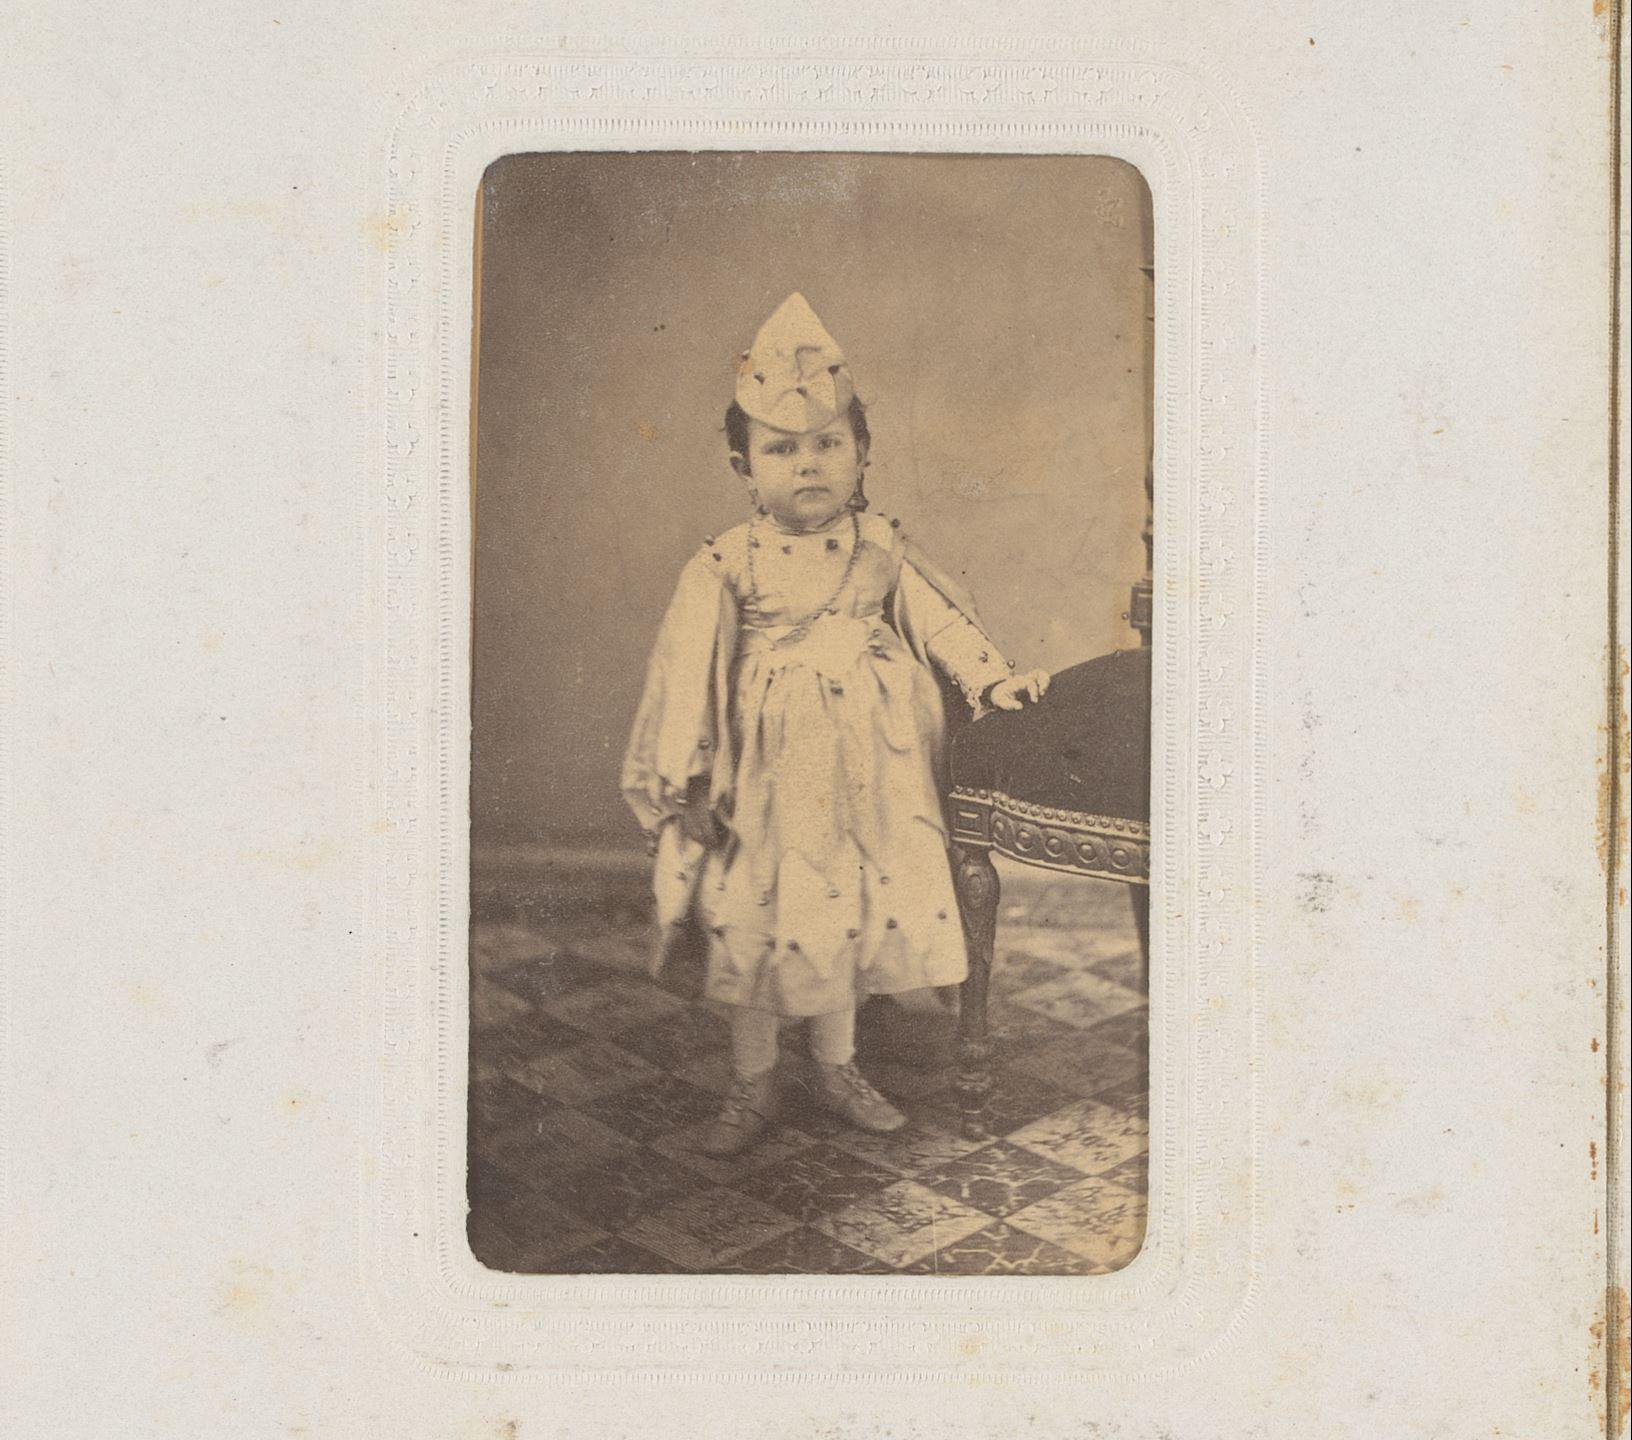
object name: photograph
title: Portret van een kind in kostuum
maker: Anonymous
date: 1860-1890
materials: cardboard, photographic support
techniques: albumen print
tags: child, clothes, costume